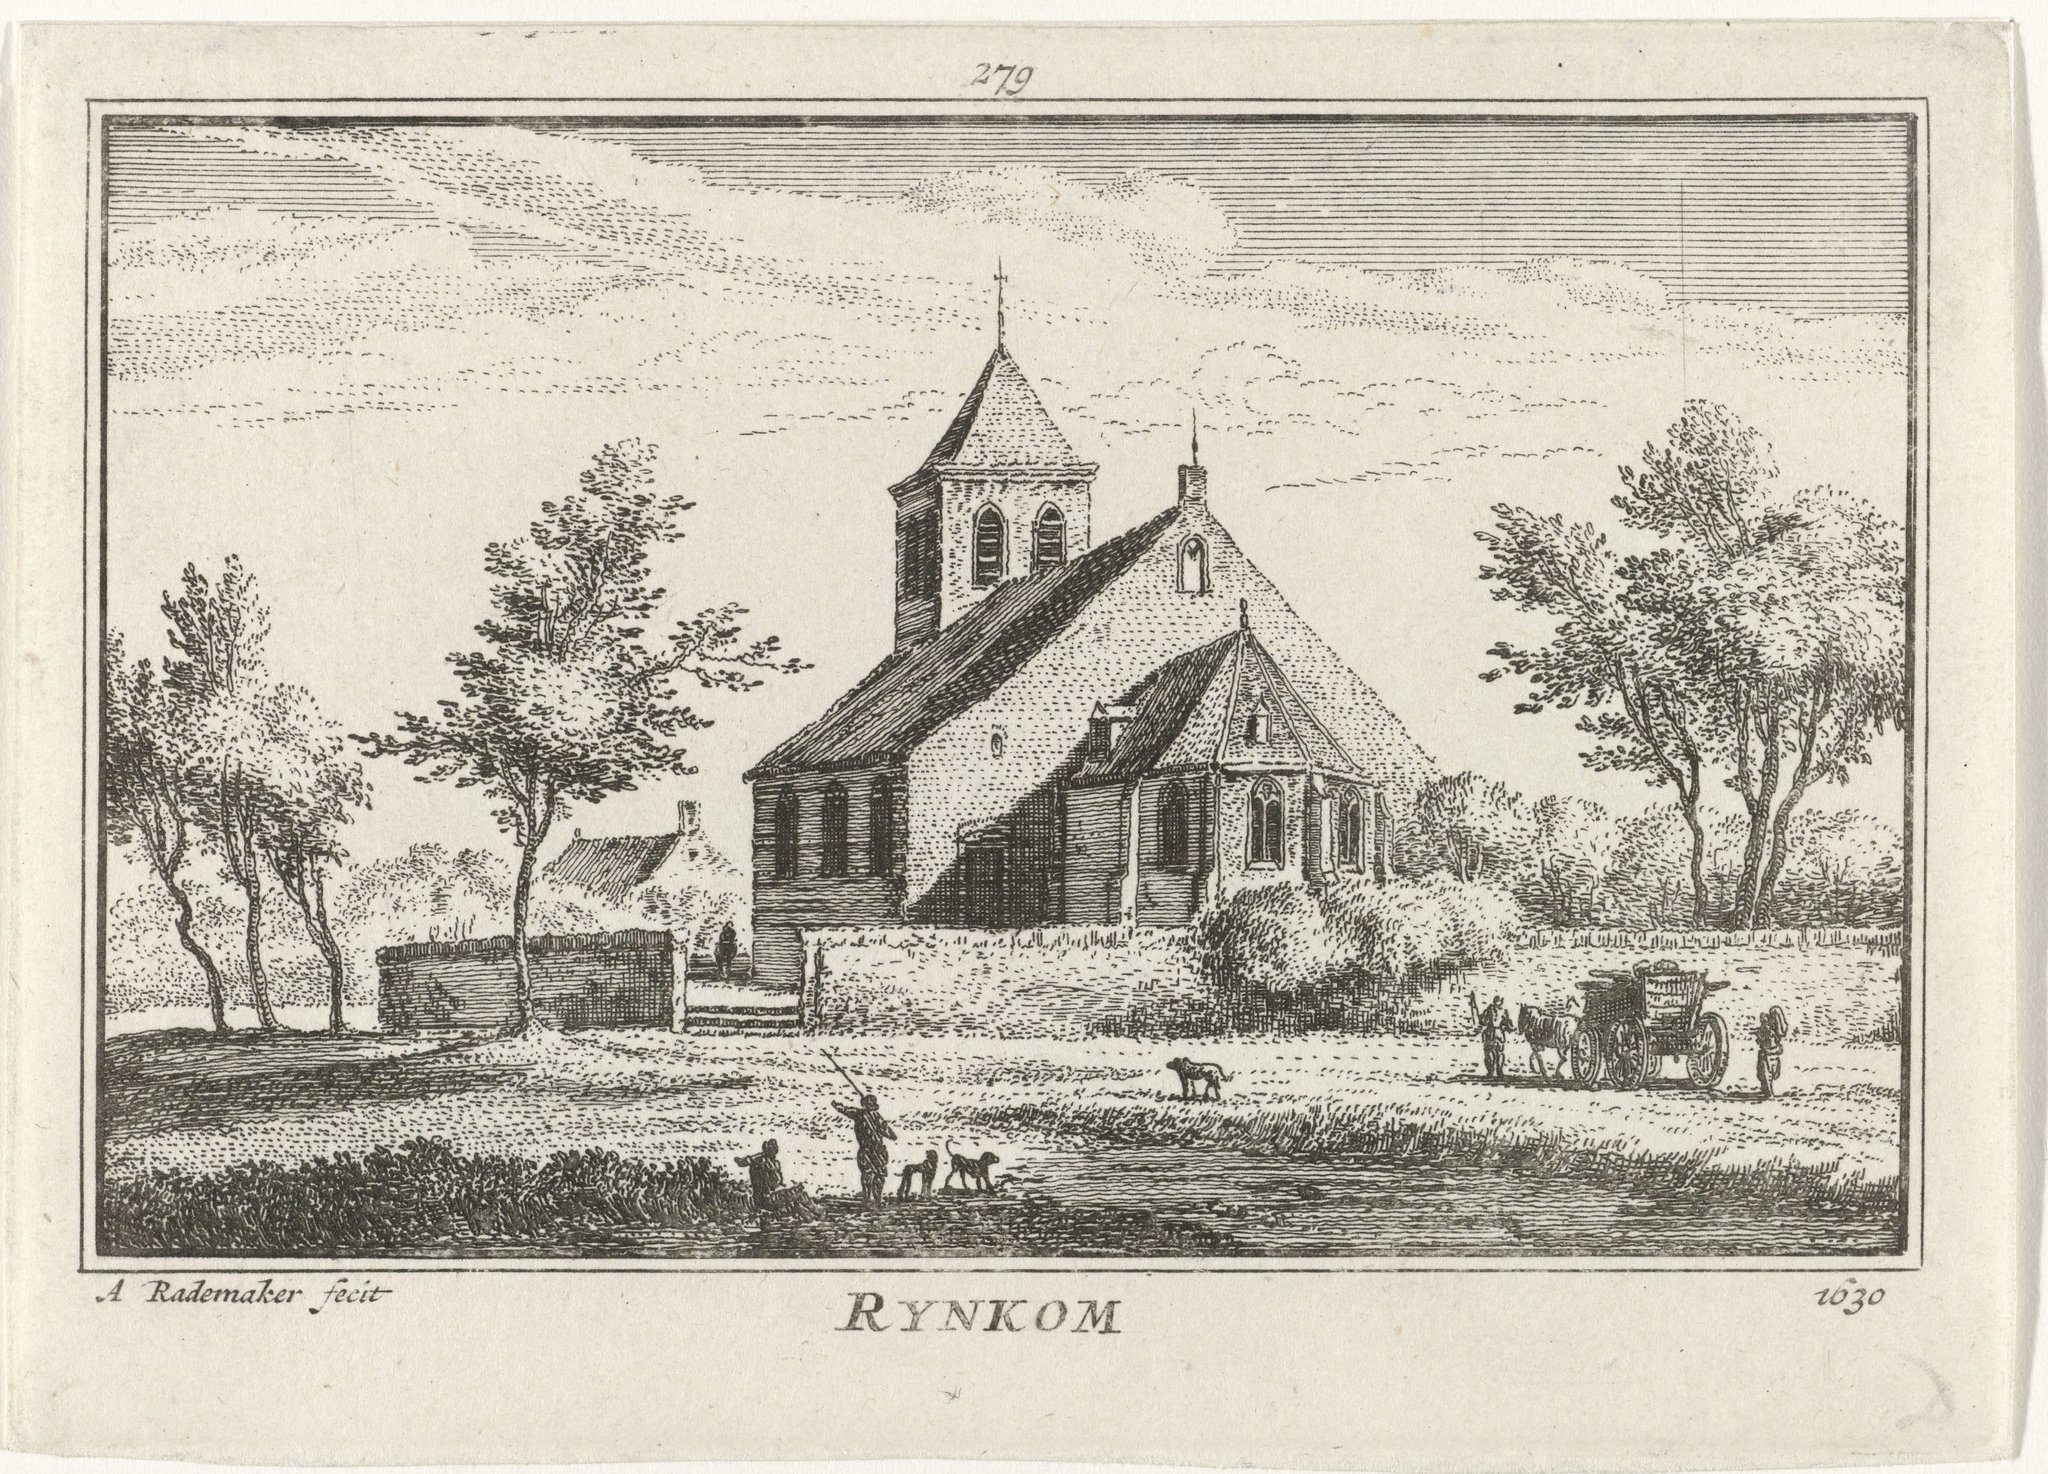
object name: book illustration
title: Rynkom 1630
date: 1727-1733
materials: paper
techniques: etching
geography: amsterdam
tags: four-wheeled vehicle drawn by one animal, farmers, dog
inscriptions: collector's mark: Lugt 2228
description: Illustratie uit: Abraham Rademaker, Matthaeus Brouërius van Niedek, Isaac Le Long, Kabinet van Nederlandsche en Kleefsche outheden en (...) voorname stads- en landgebouwen, Willem Barents en Antoni Schoonenburg: Amsterdam, 1727-1733, ill. nr. 279.